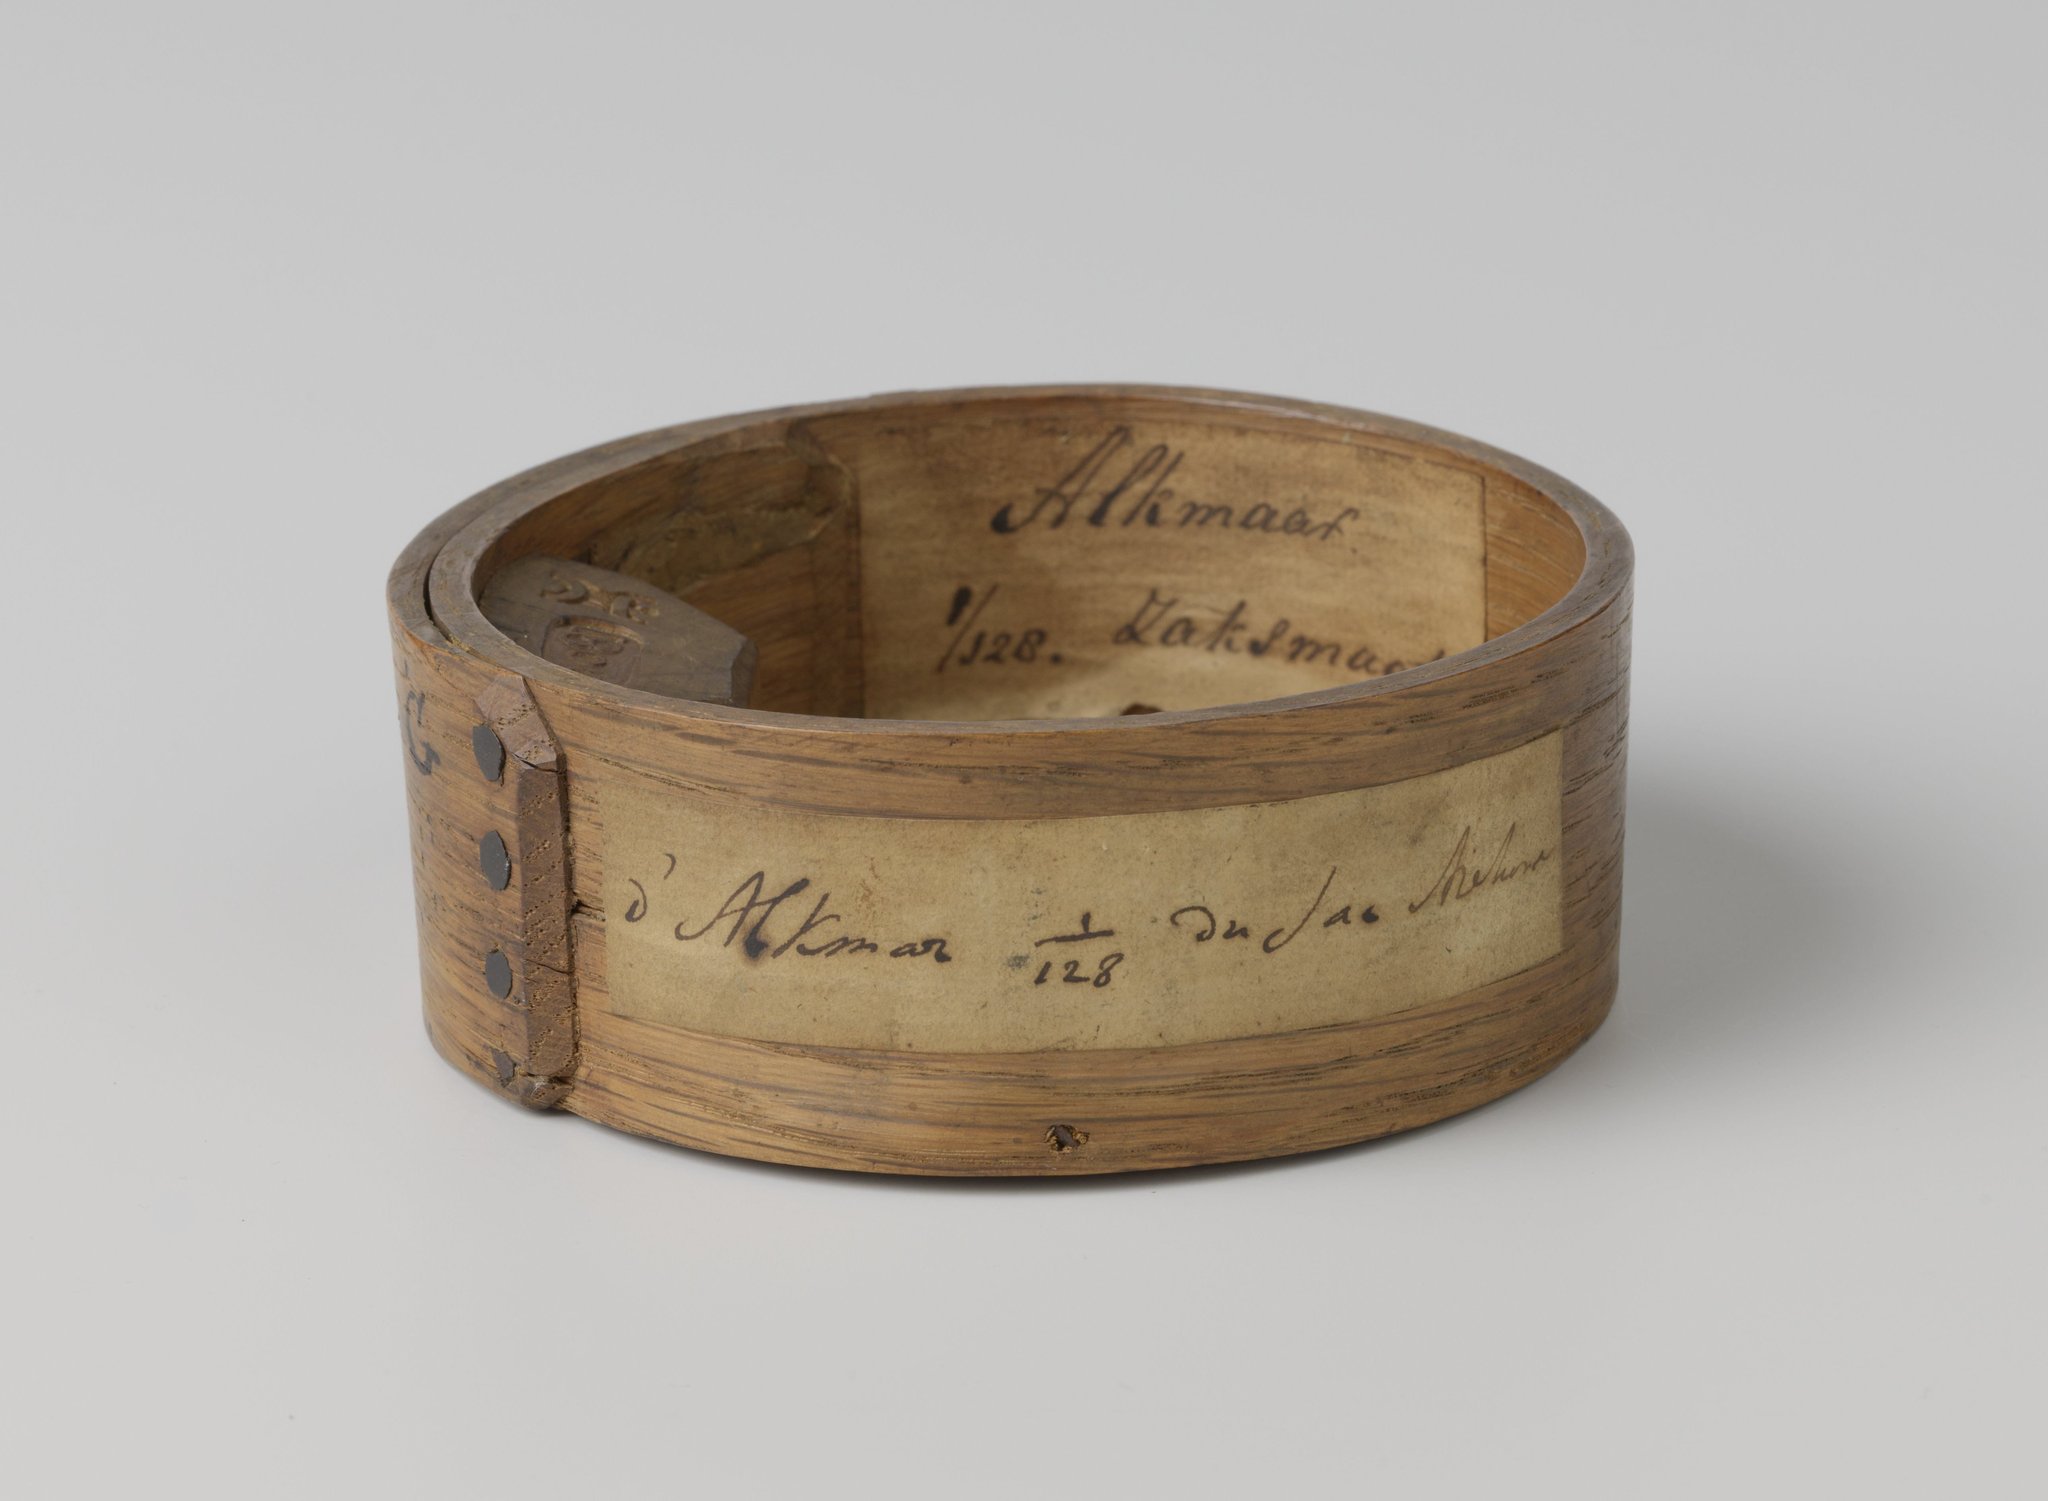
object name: zaksmaat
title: Alkmaar 1/128 zaksmaat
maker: Anonymous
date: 1800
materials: wood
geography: alkmaar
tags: alkmaar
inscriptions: title: ‘d'Alkmaar 1/128 du Sac Mesure’, inscription: ‘G’, : ‘1800’, title: ‘Alkmaar 1/128 Zaksmaat’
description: Spanen maat van 1/128 zak, voorzien van ijkmerk en etiketten.